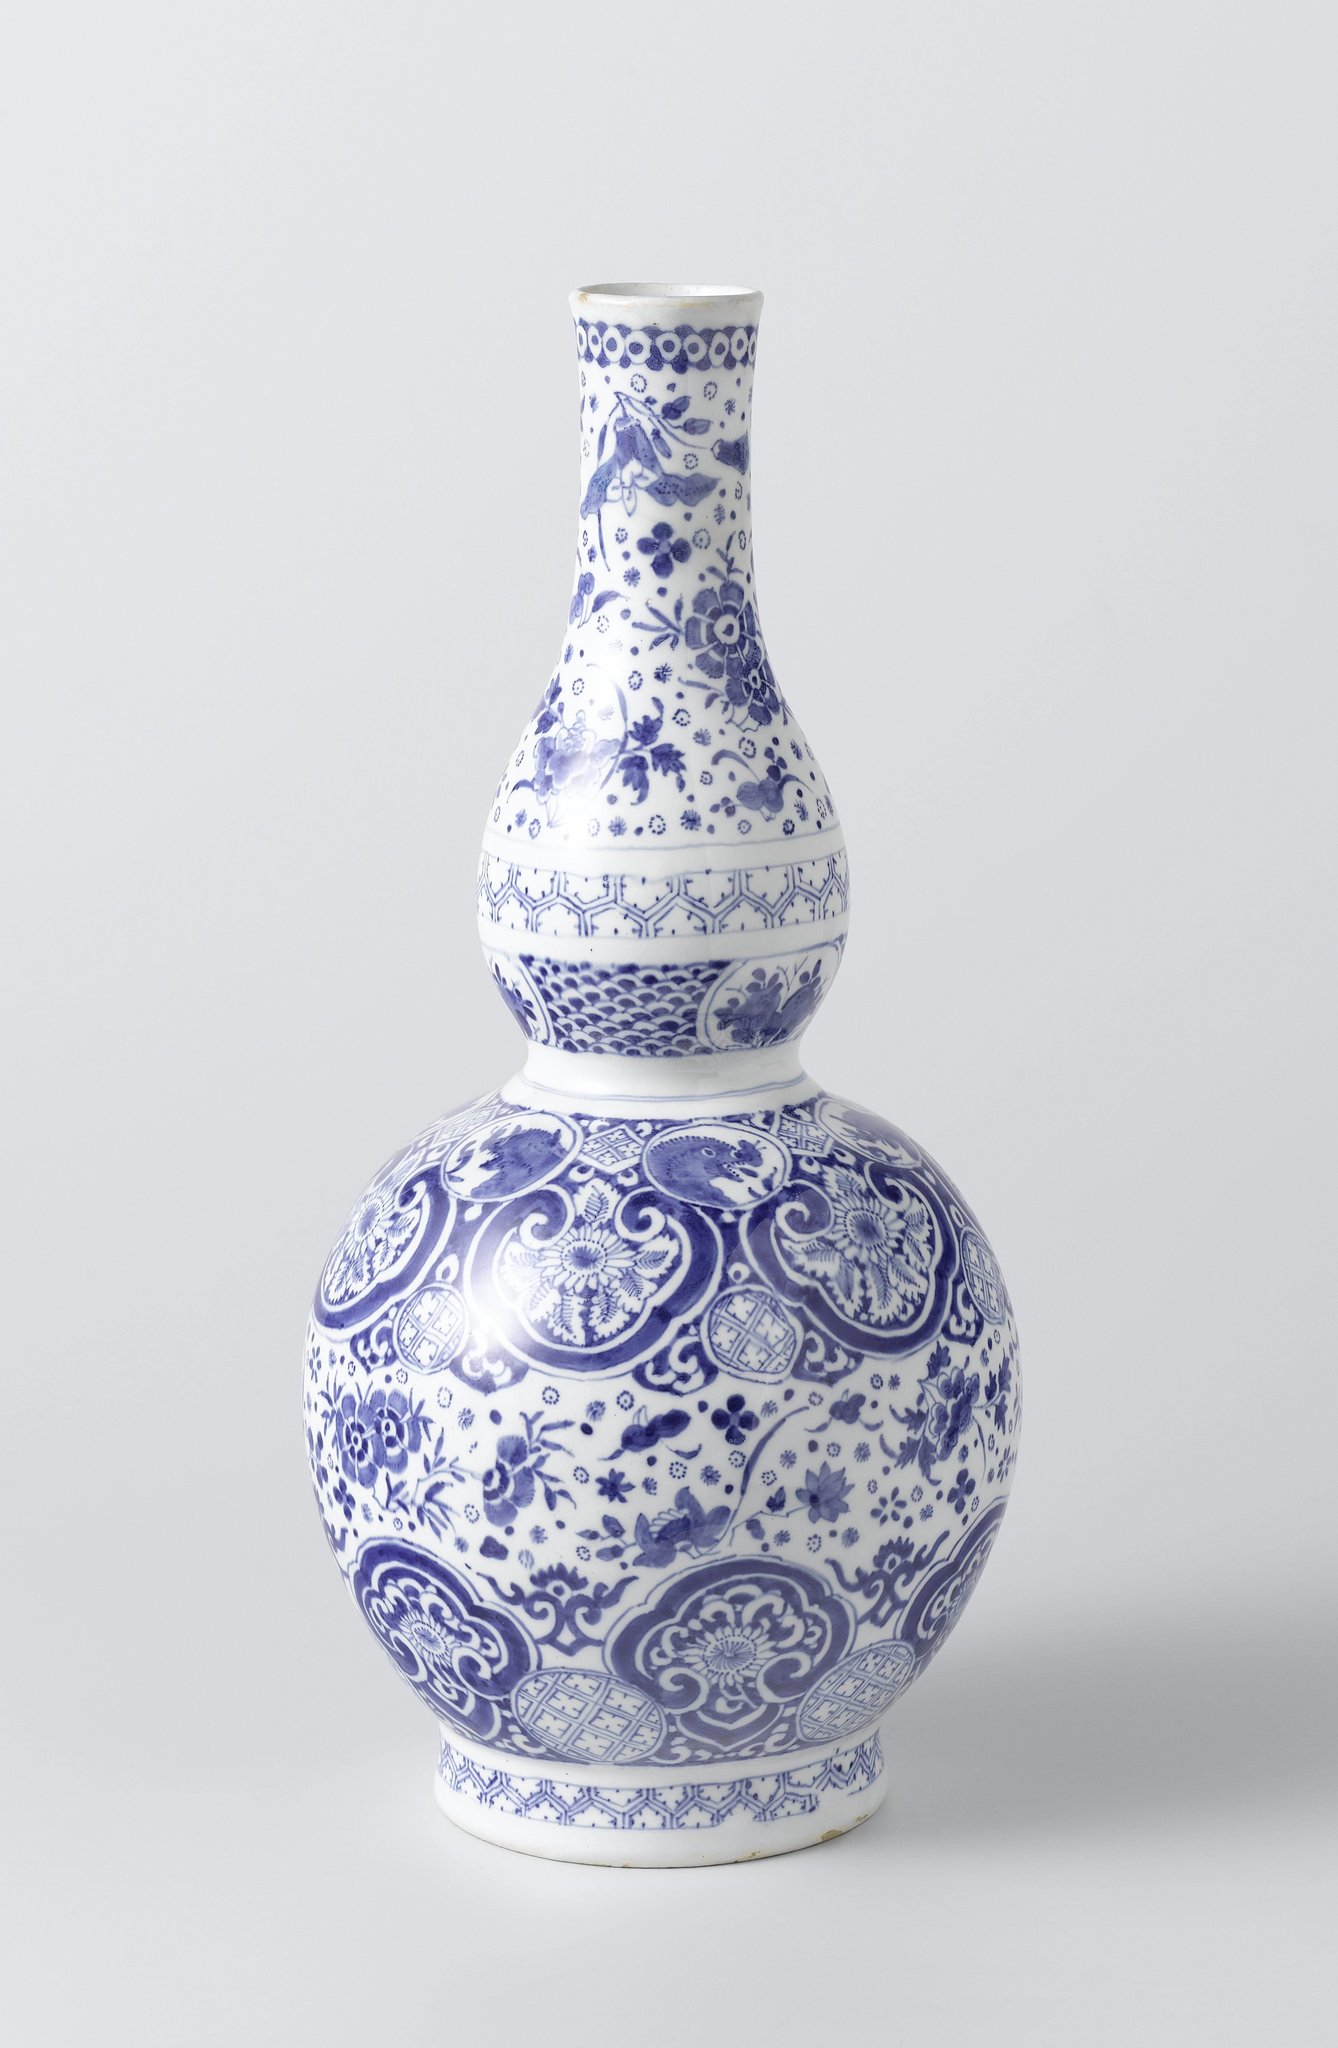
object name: vase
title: Vaas van faience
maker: adrianus kocx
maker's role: plateelbakker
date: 1687-1701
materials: earthenware, glaze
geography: delft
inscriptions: mark: ‘AK(ineen)’, seal: ‘1137’